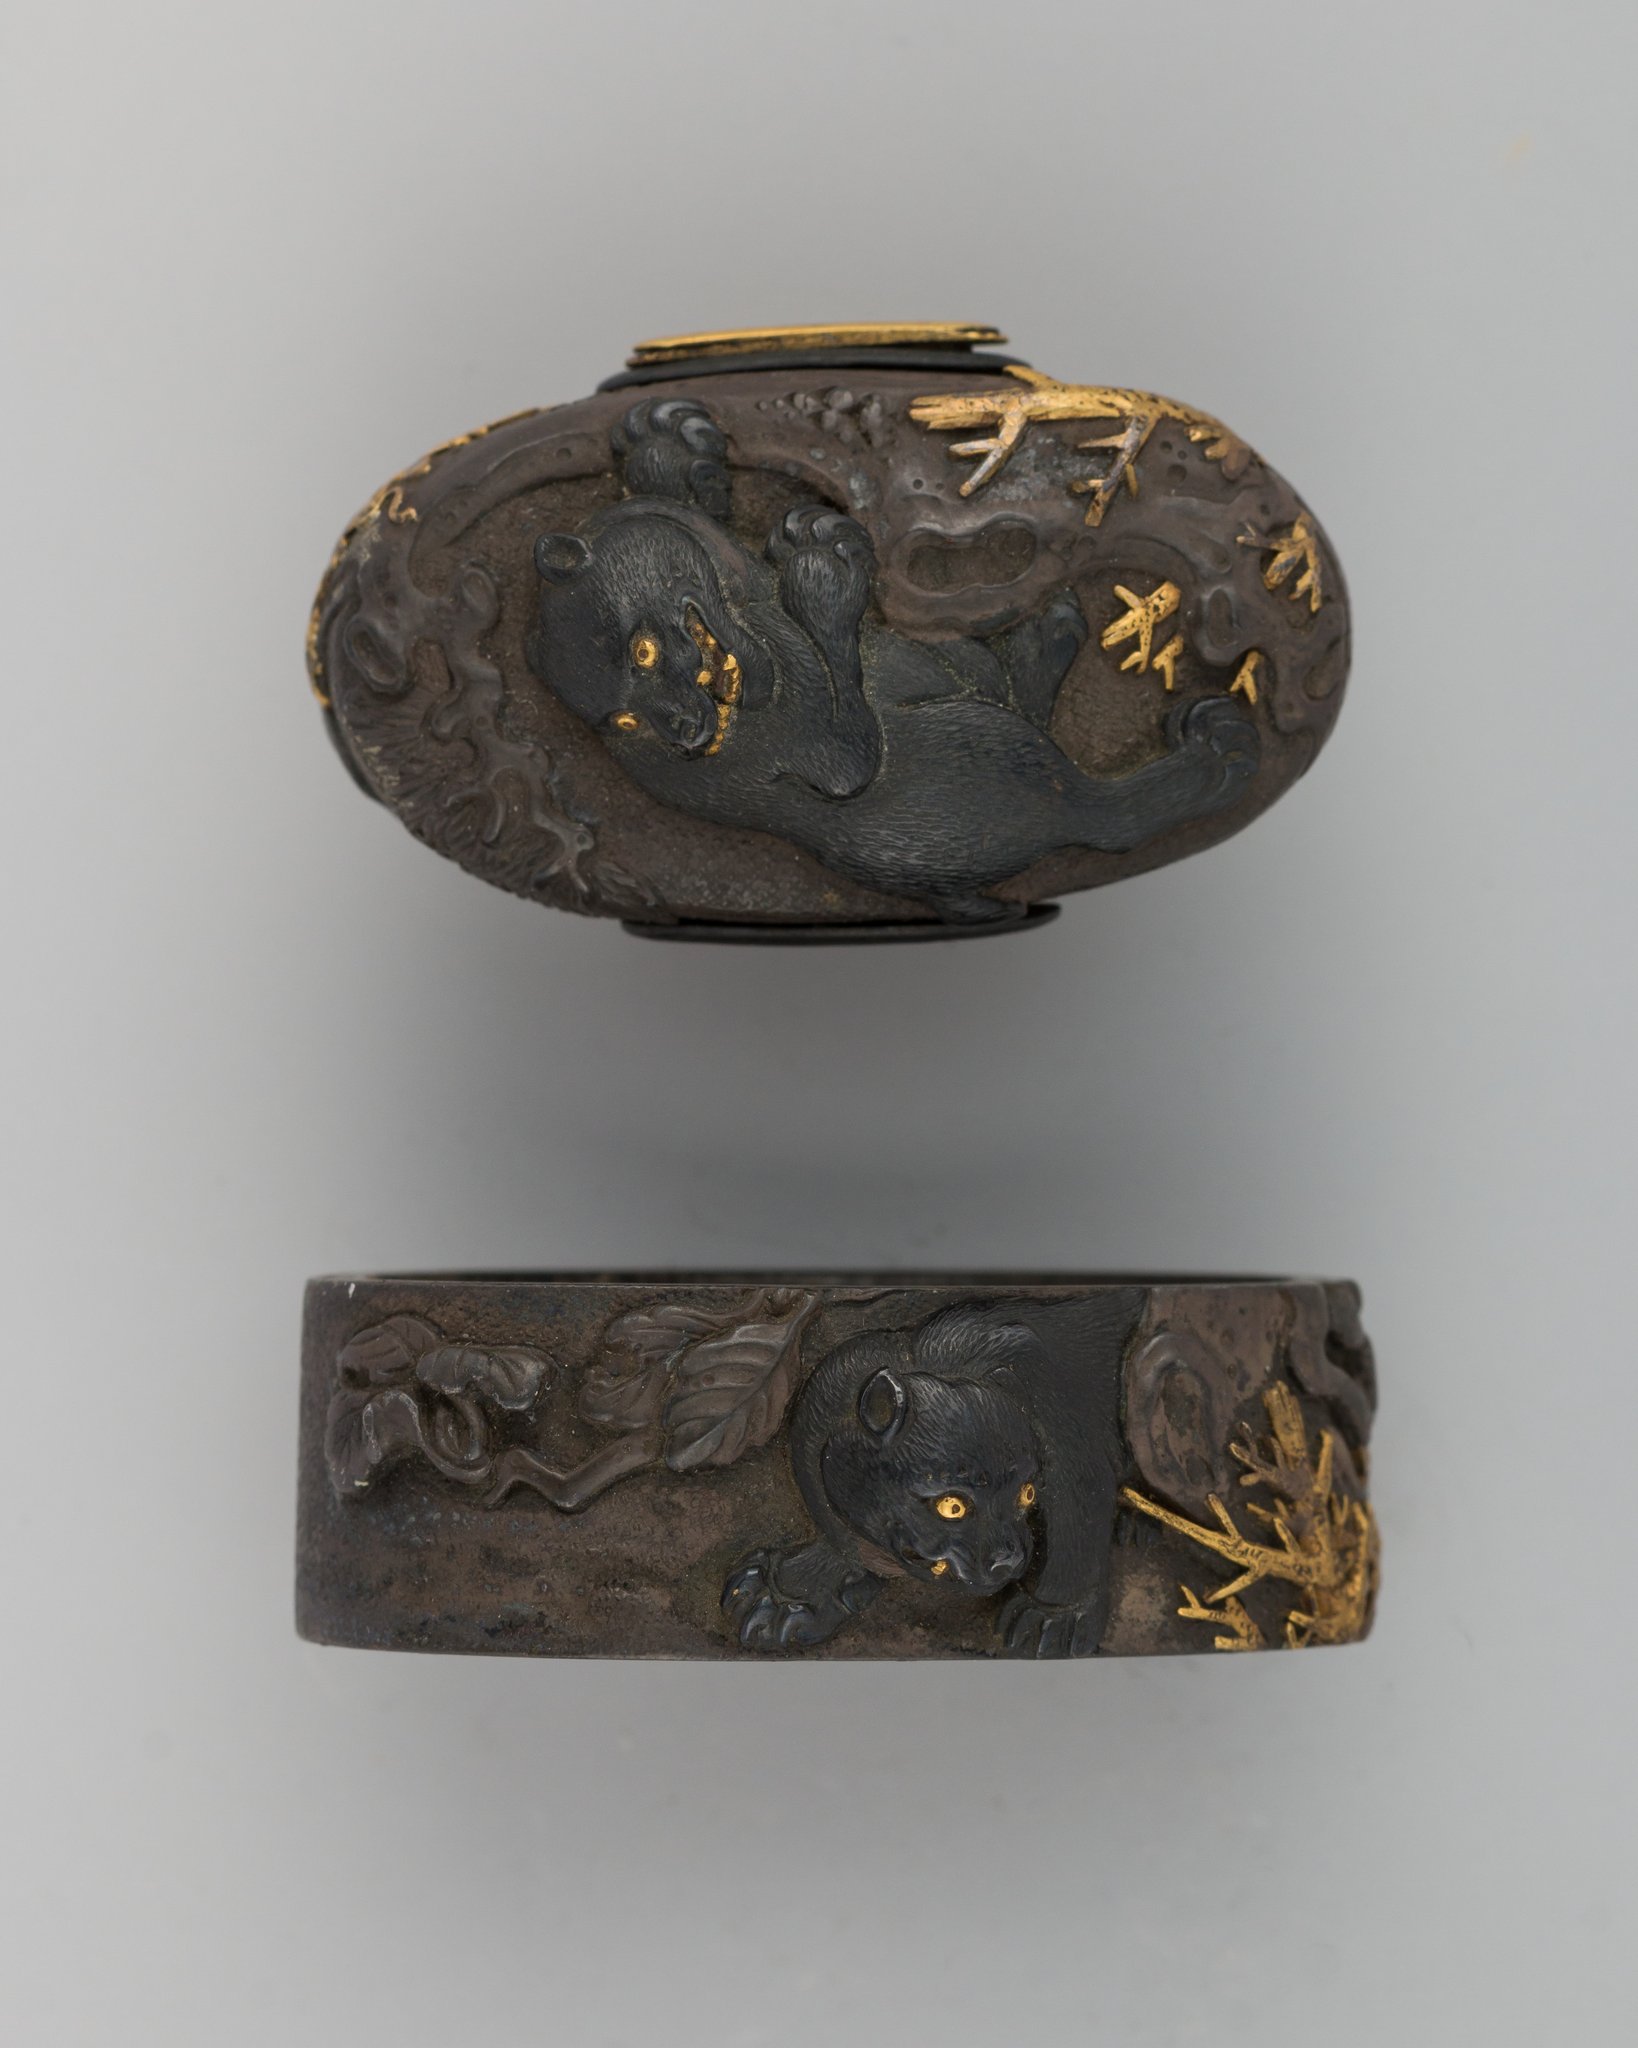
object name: sword hilt collar and pommel fuchigashira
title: Sword-Hilt Collar and Pommel (Fuchigashira)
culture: japanese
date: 1615-1868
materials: gold alloy, silver alloy, gold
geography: japan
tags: animals